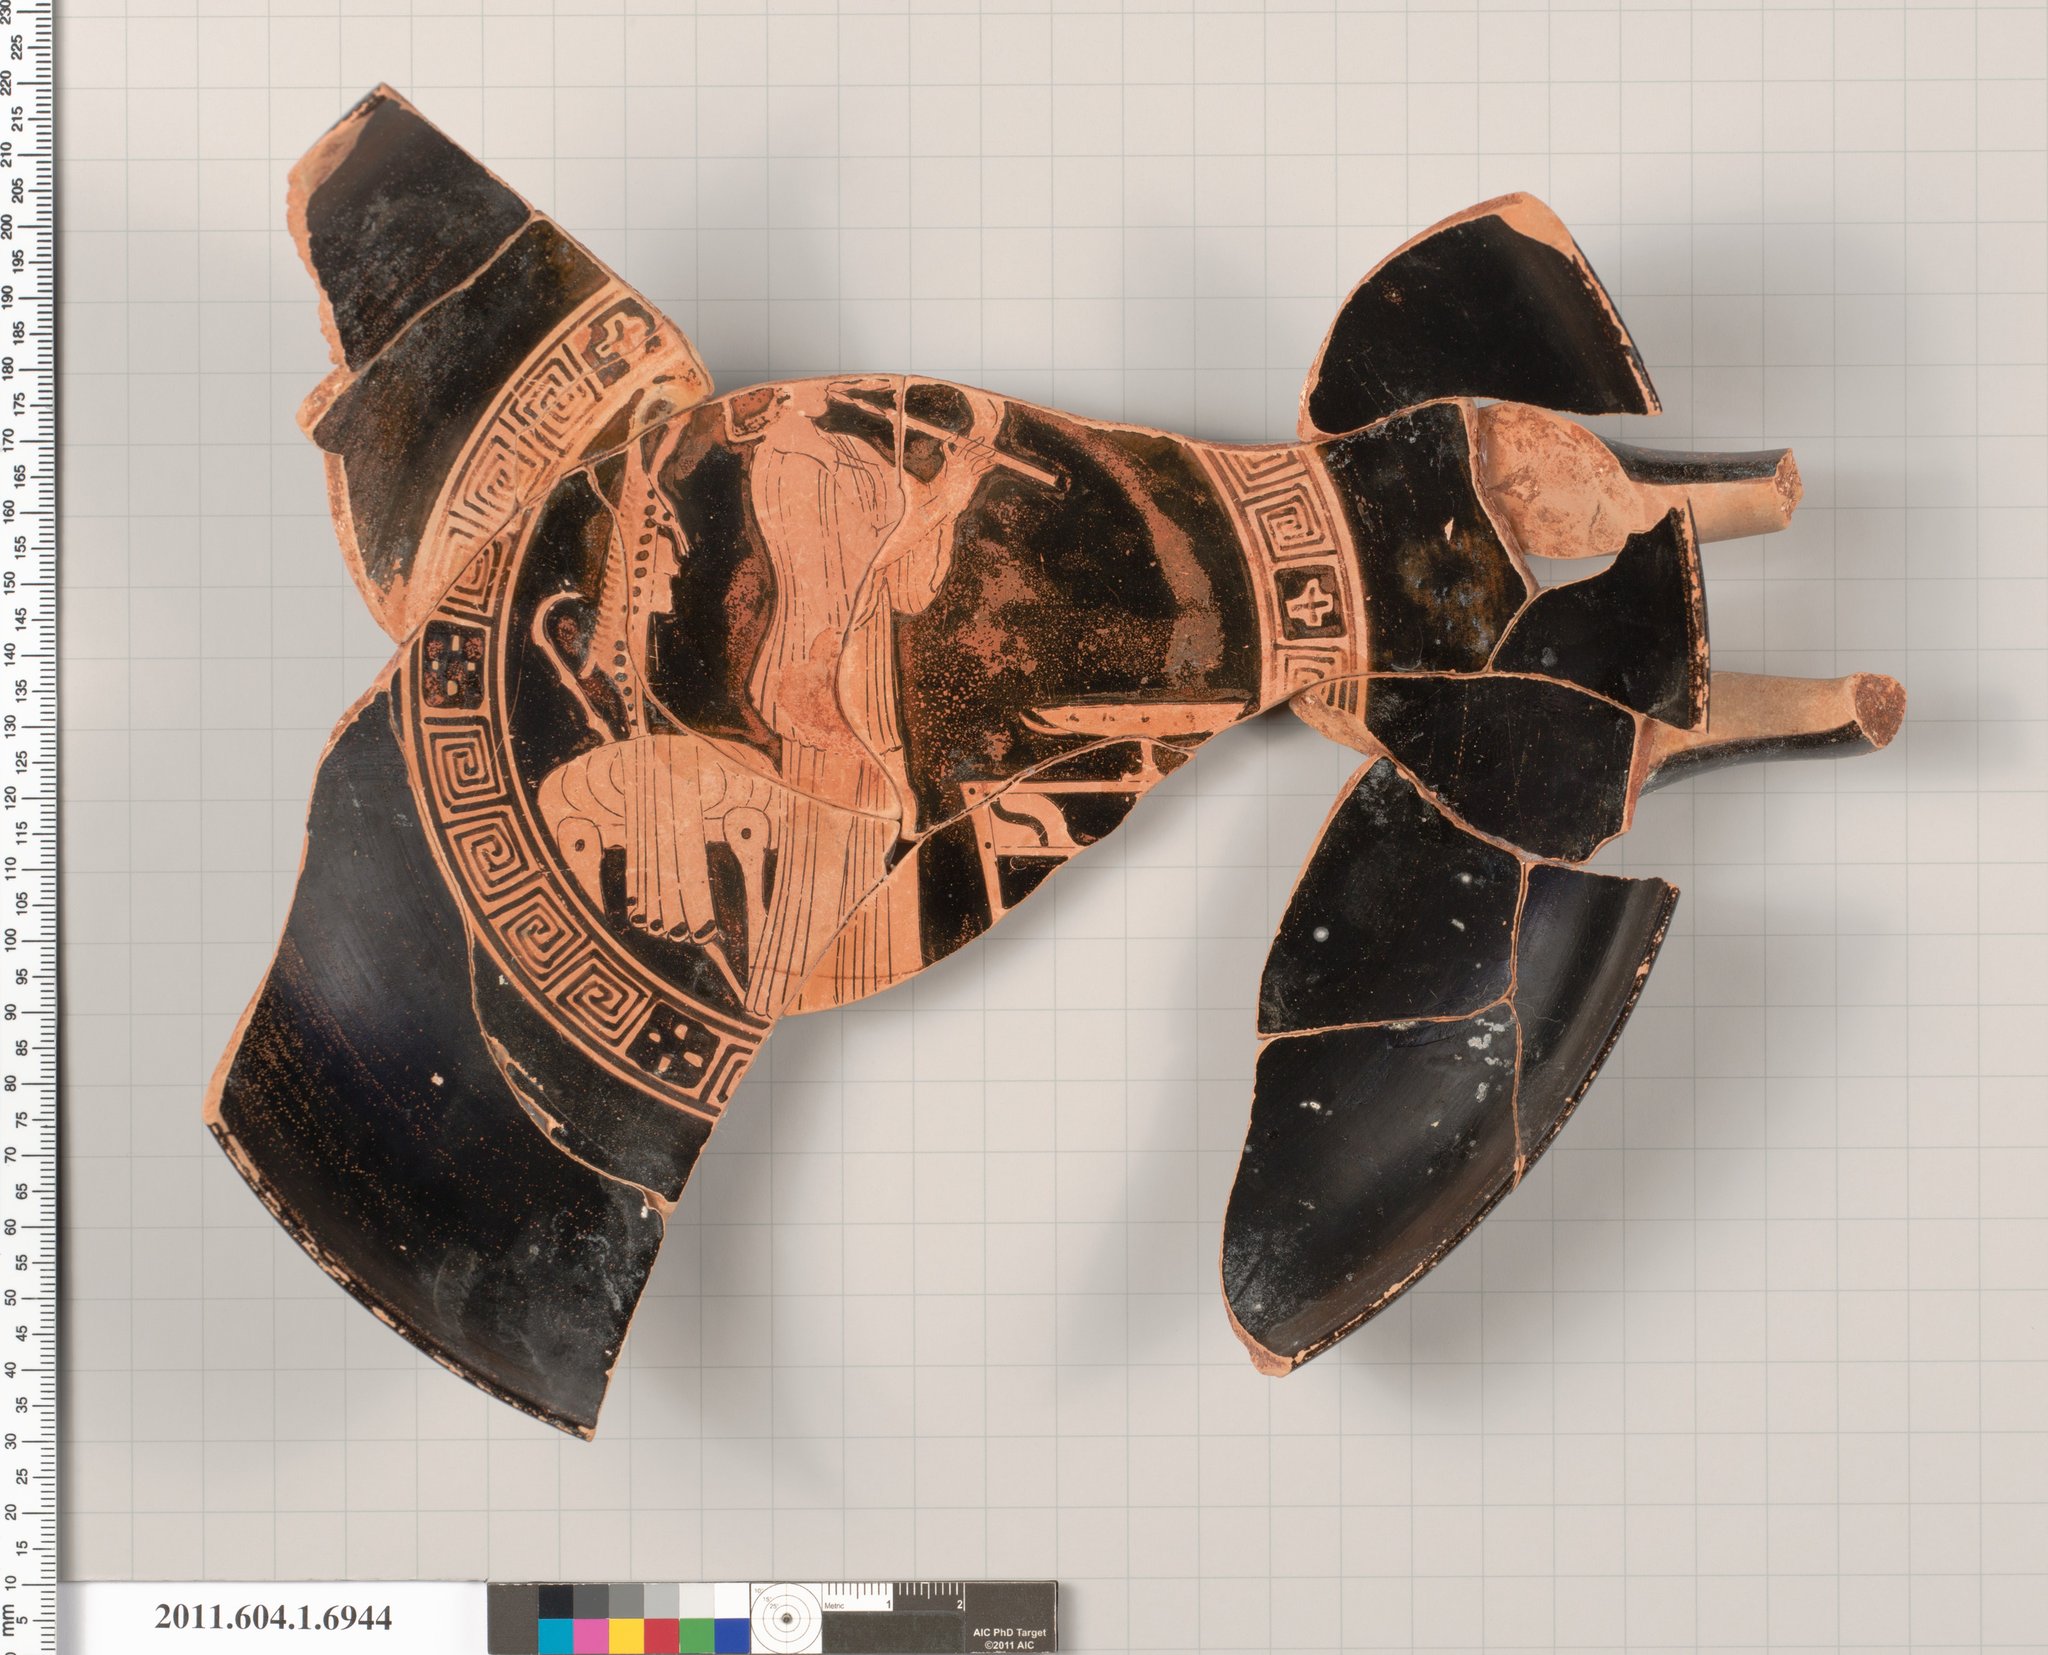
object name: kylix fragment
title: Terracotta fragment of a kylix (drinking cup)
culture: greek, attic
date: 490-470 BCE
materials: terracotta